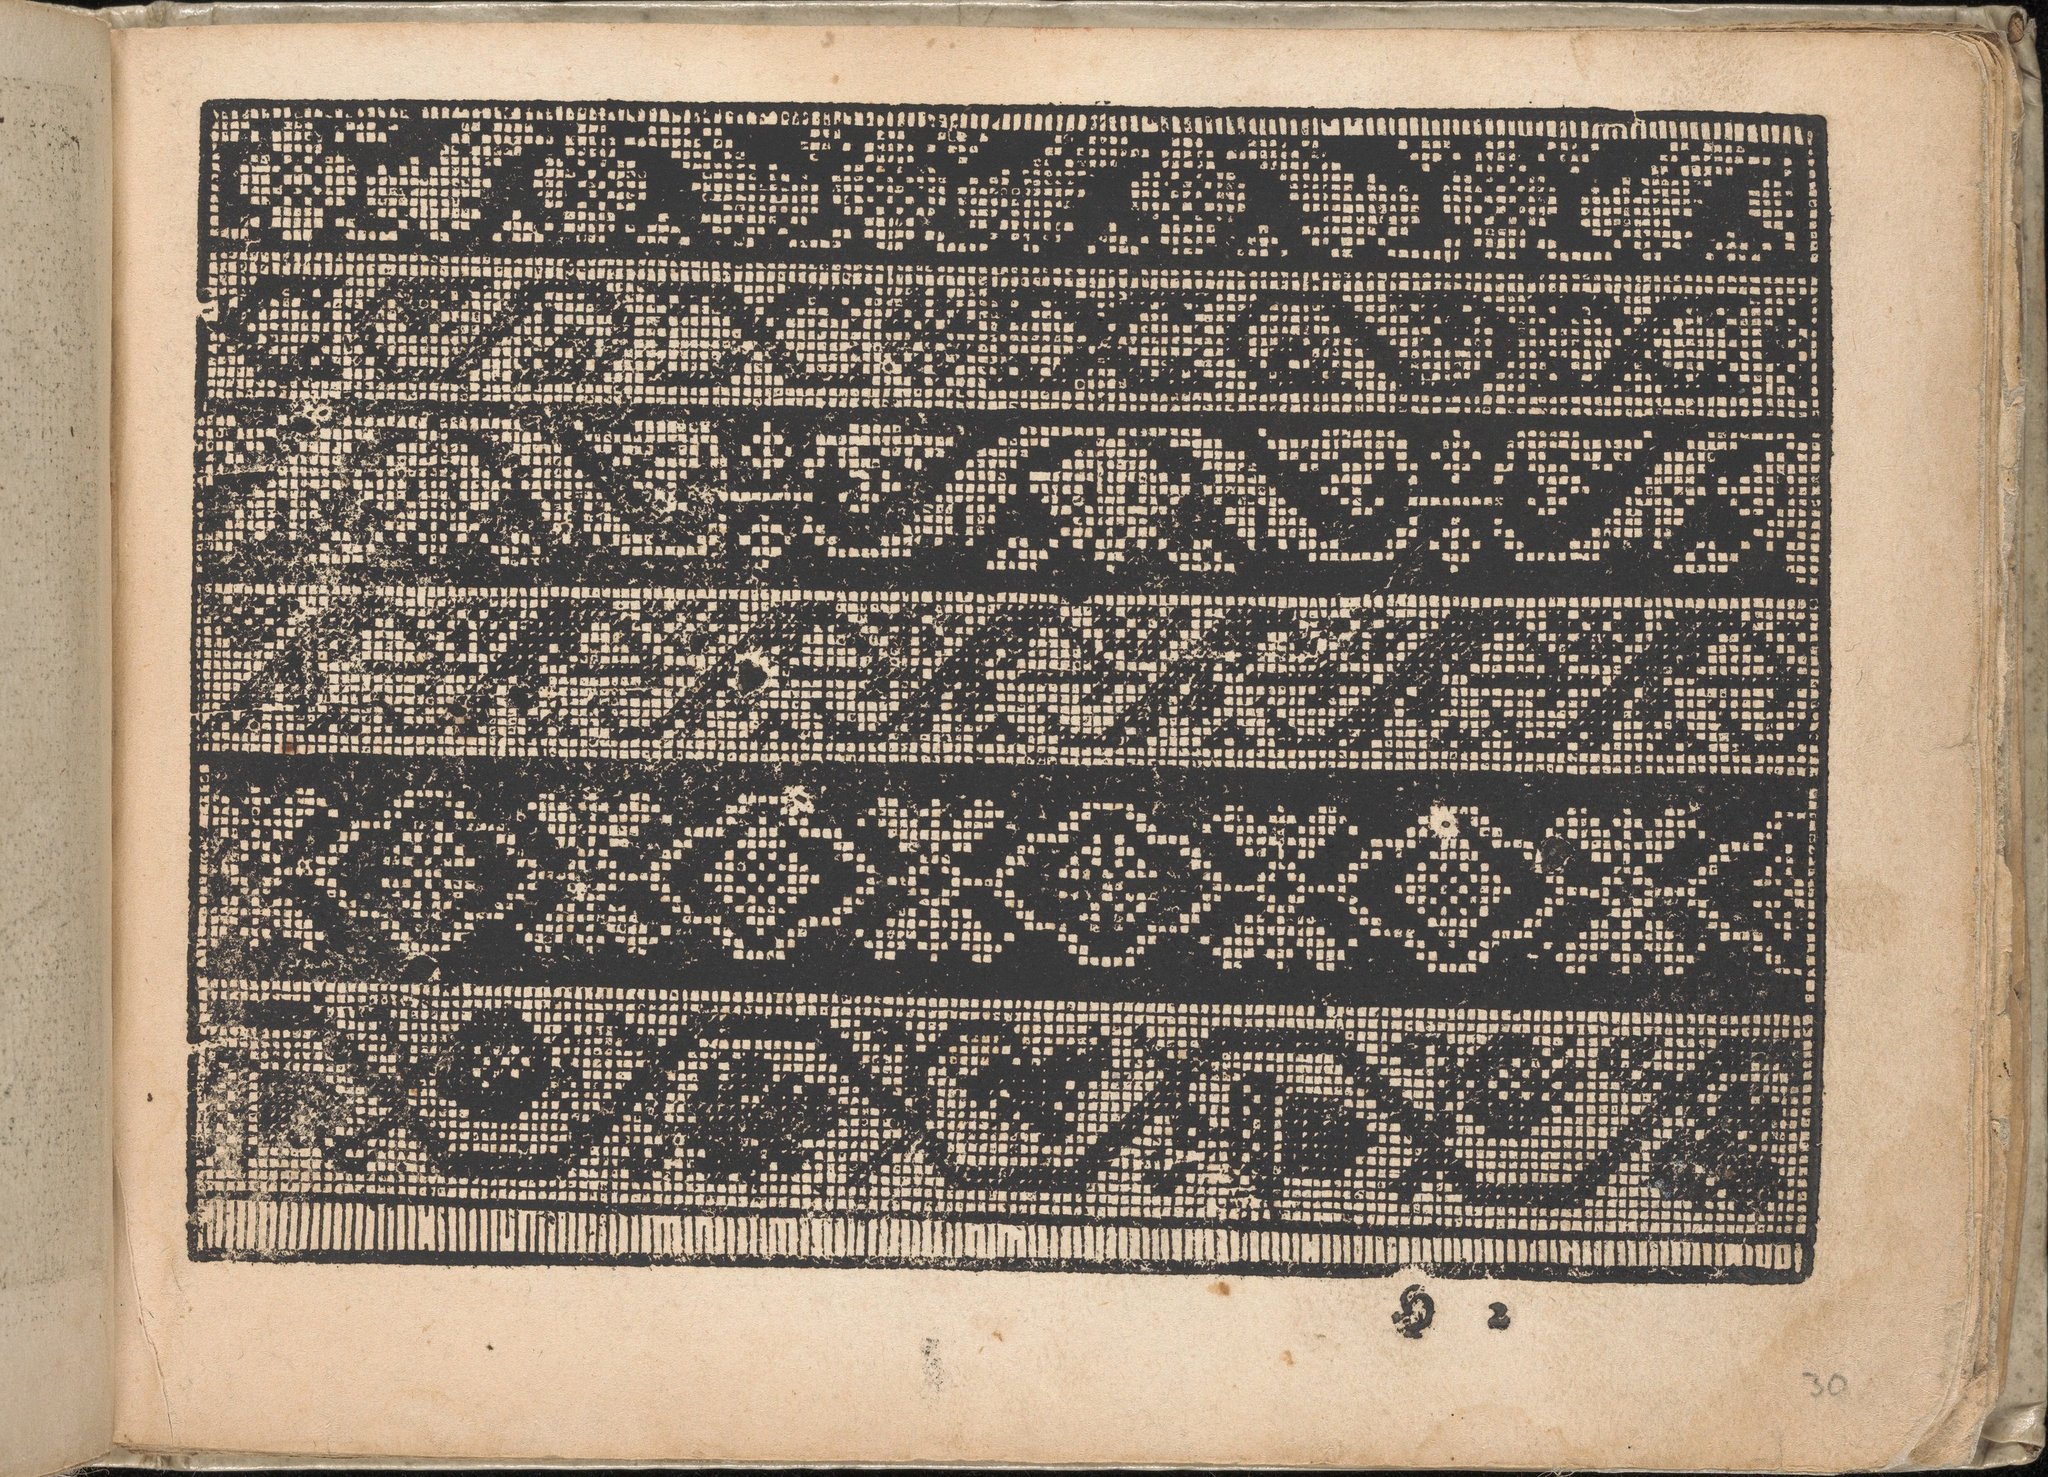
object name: book print ornament architecture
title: Neu künstlich Modelbuch (page 30r)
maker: bernhard jobin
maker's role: publisher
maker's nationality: swiss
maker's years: 1535-1597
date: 1598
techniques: woodcut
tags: flowers